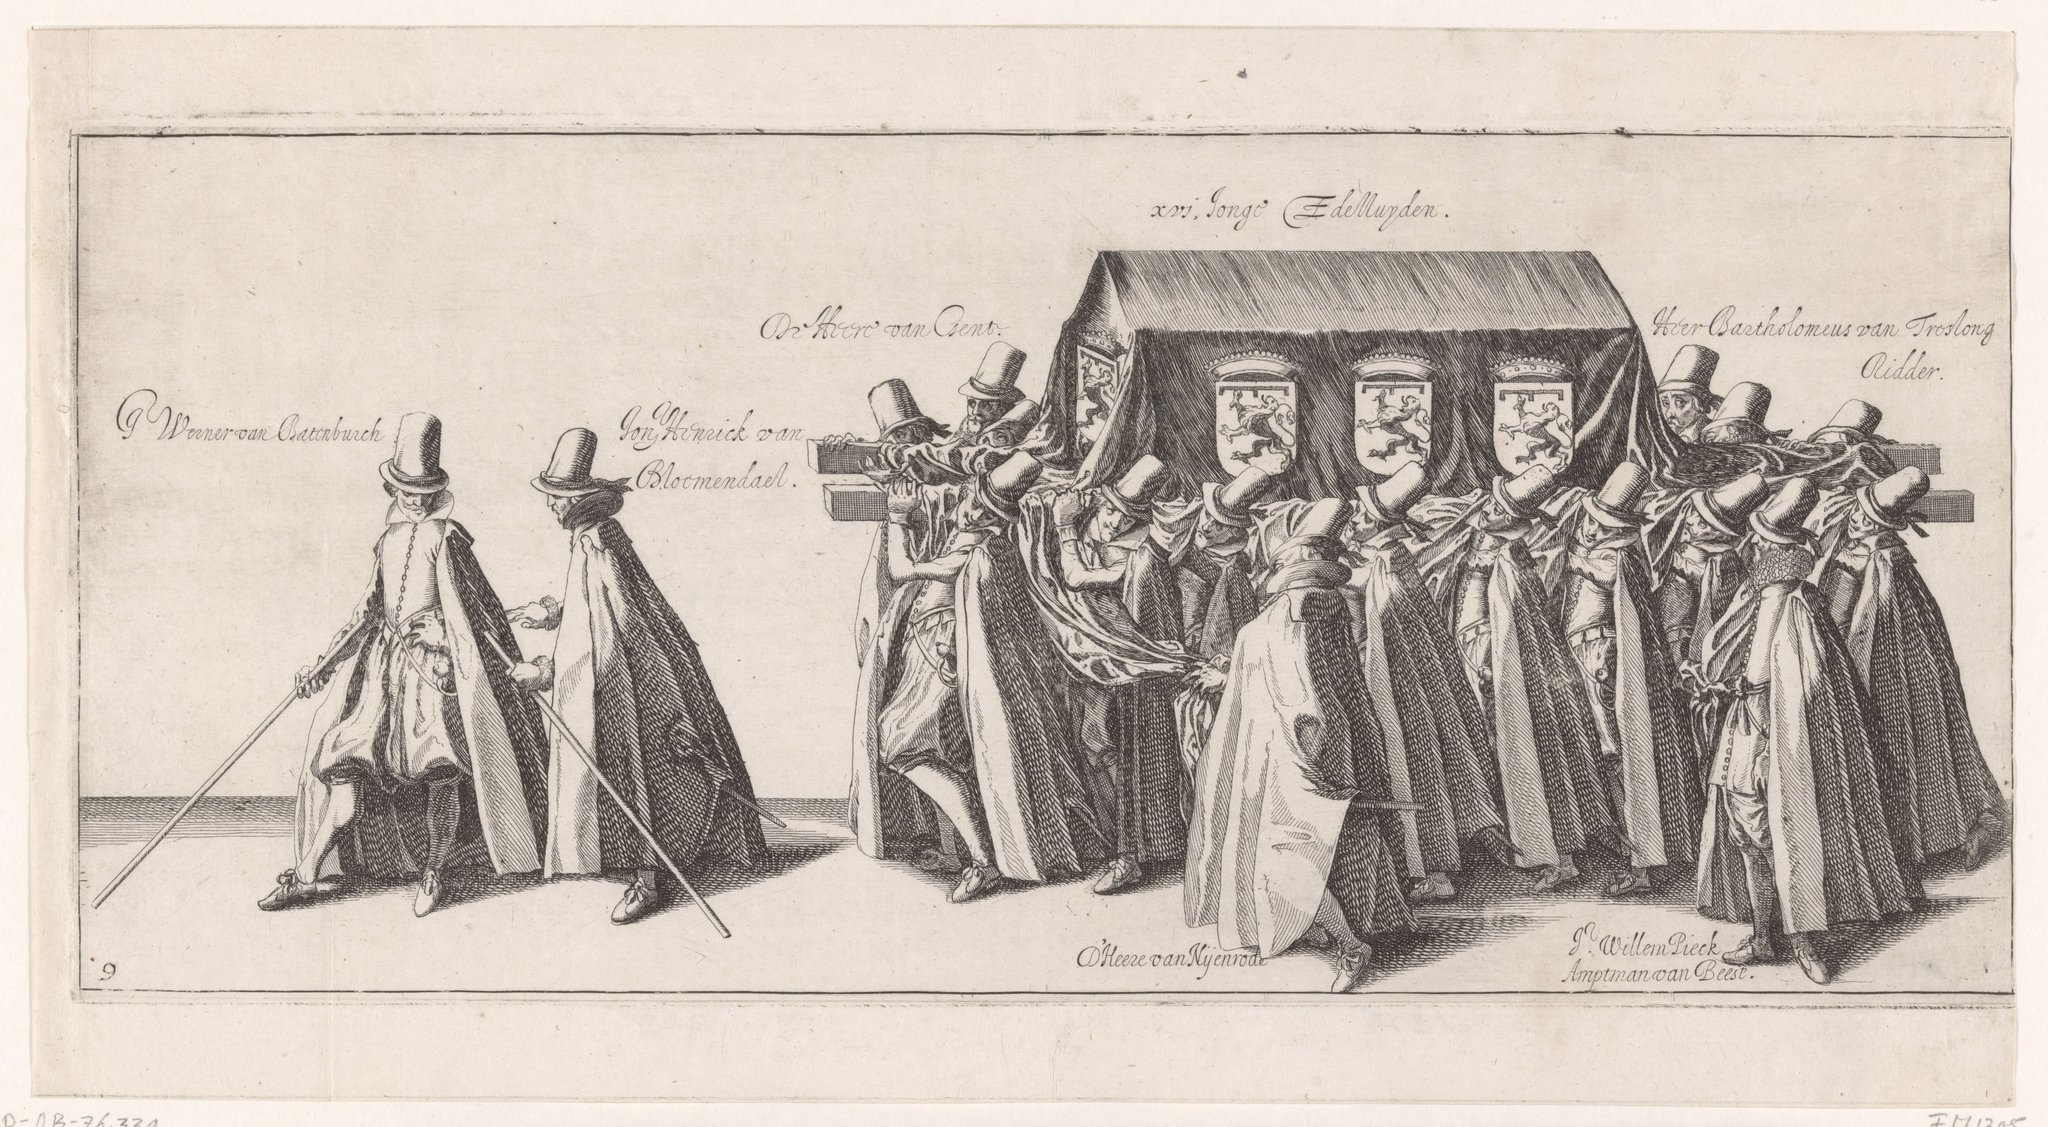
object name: print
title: Beschryvinge vande begraefnisse van (...) Walraven, Heere tot Brederoede, Vry-Heere van Vianen (...) Gedaen binnen der stede van vianen den XXIX Januari. Ano. 1615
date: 1615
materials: paper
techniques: etching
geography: northern netherlands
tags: cortege, funeral procession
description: De begrafenisstoet met de kist (plaat 9). De lijkkist gedragen door jonge edelen. Onderdeel van de serie prenten van de begrafenisoptocht van Walraven van Brederode, heer van Vianen, op 29 januari 1615 te Vianen.